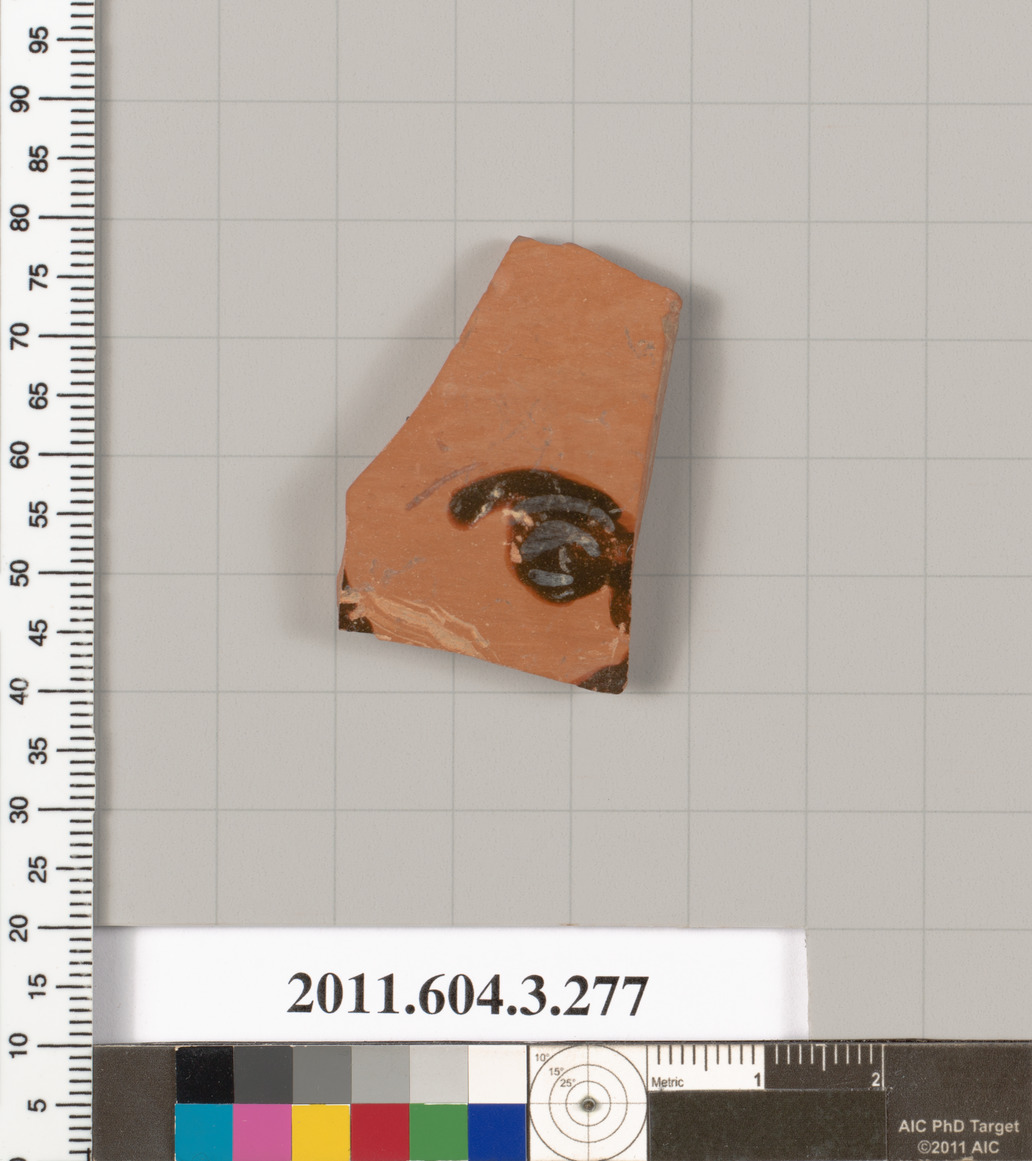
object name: neck amphora fragment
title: Terracotta fragment of a neck-amphora (jar)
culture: greek, attic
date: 534-468 BCE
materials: terracotta